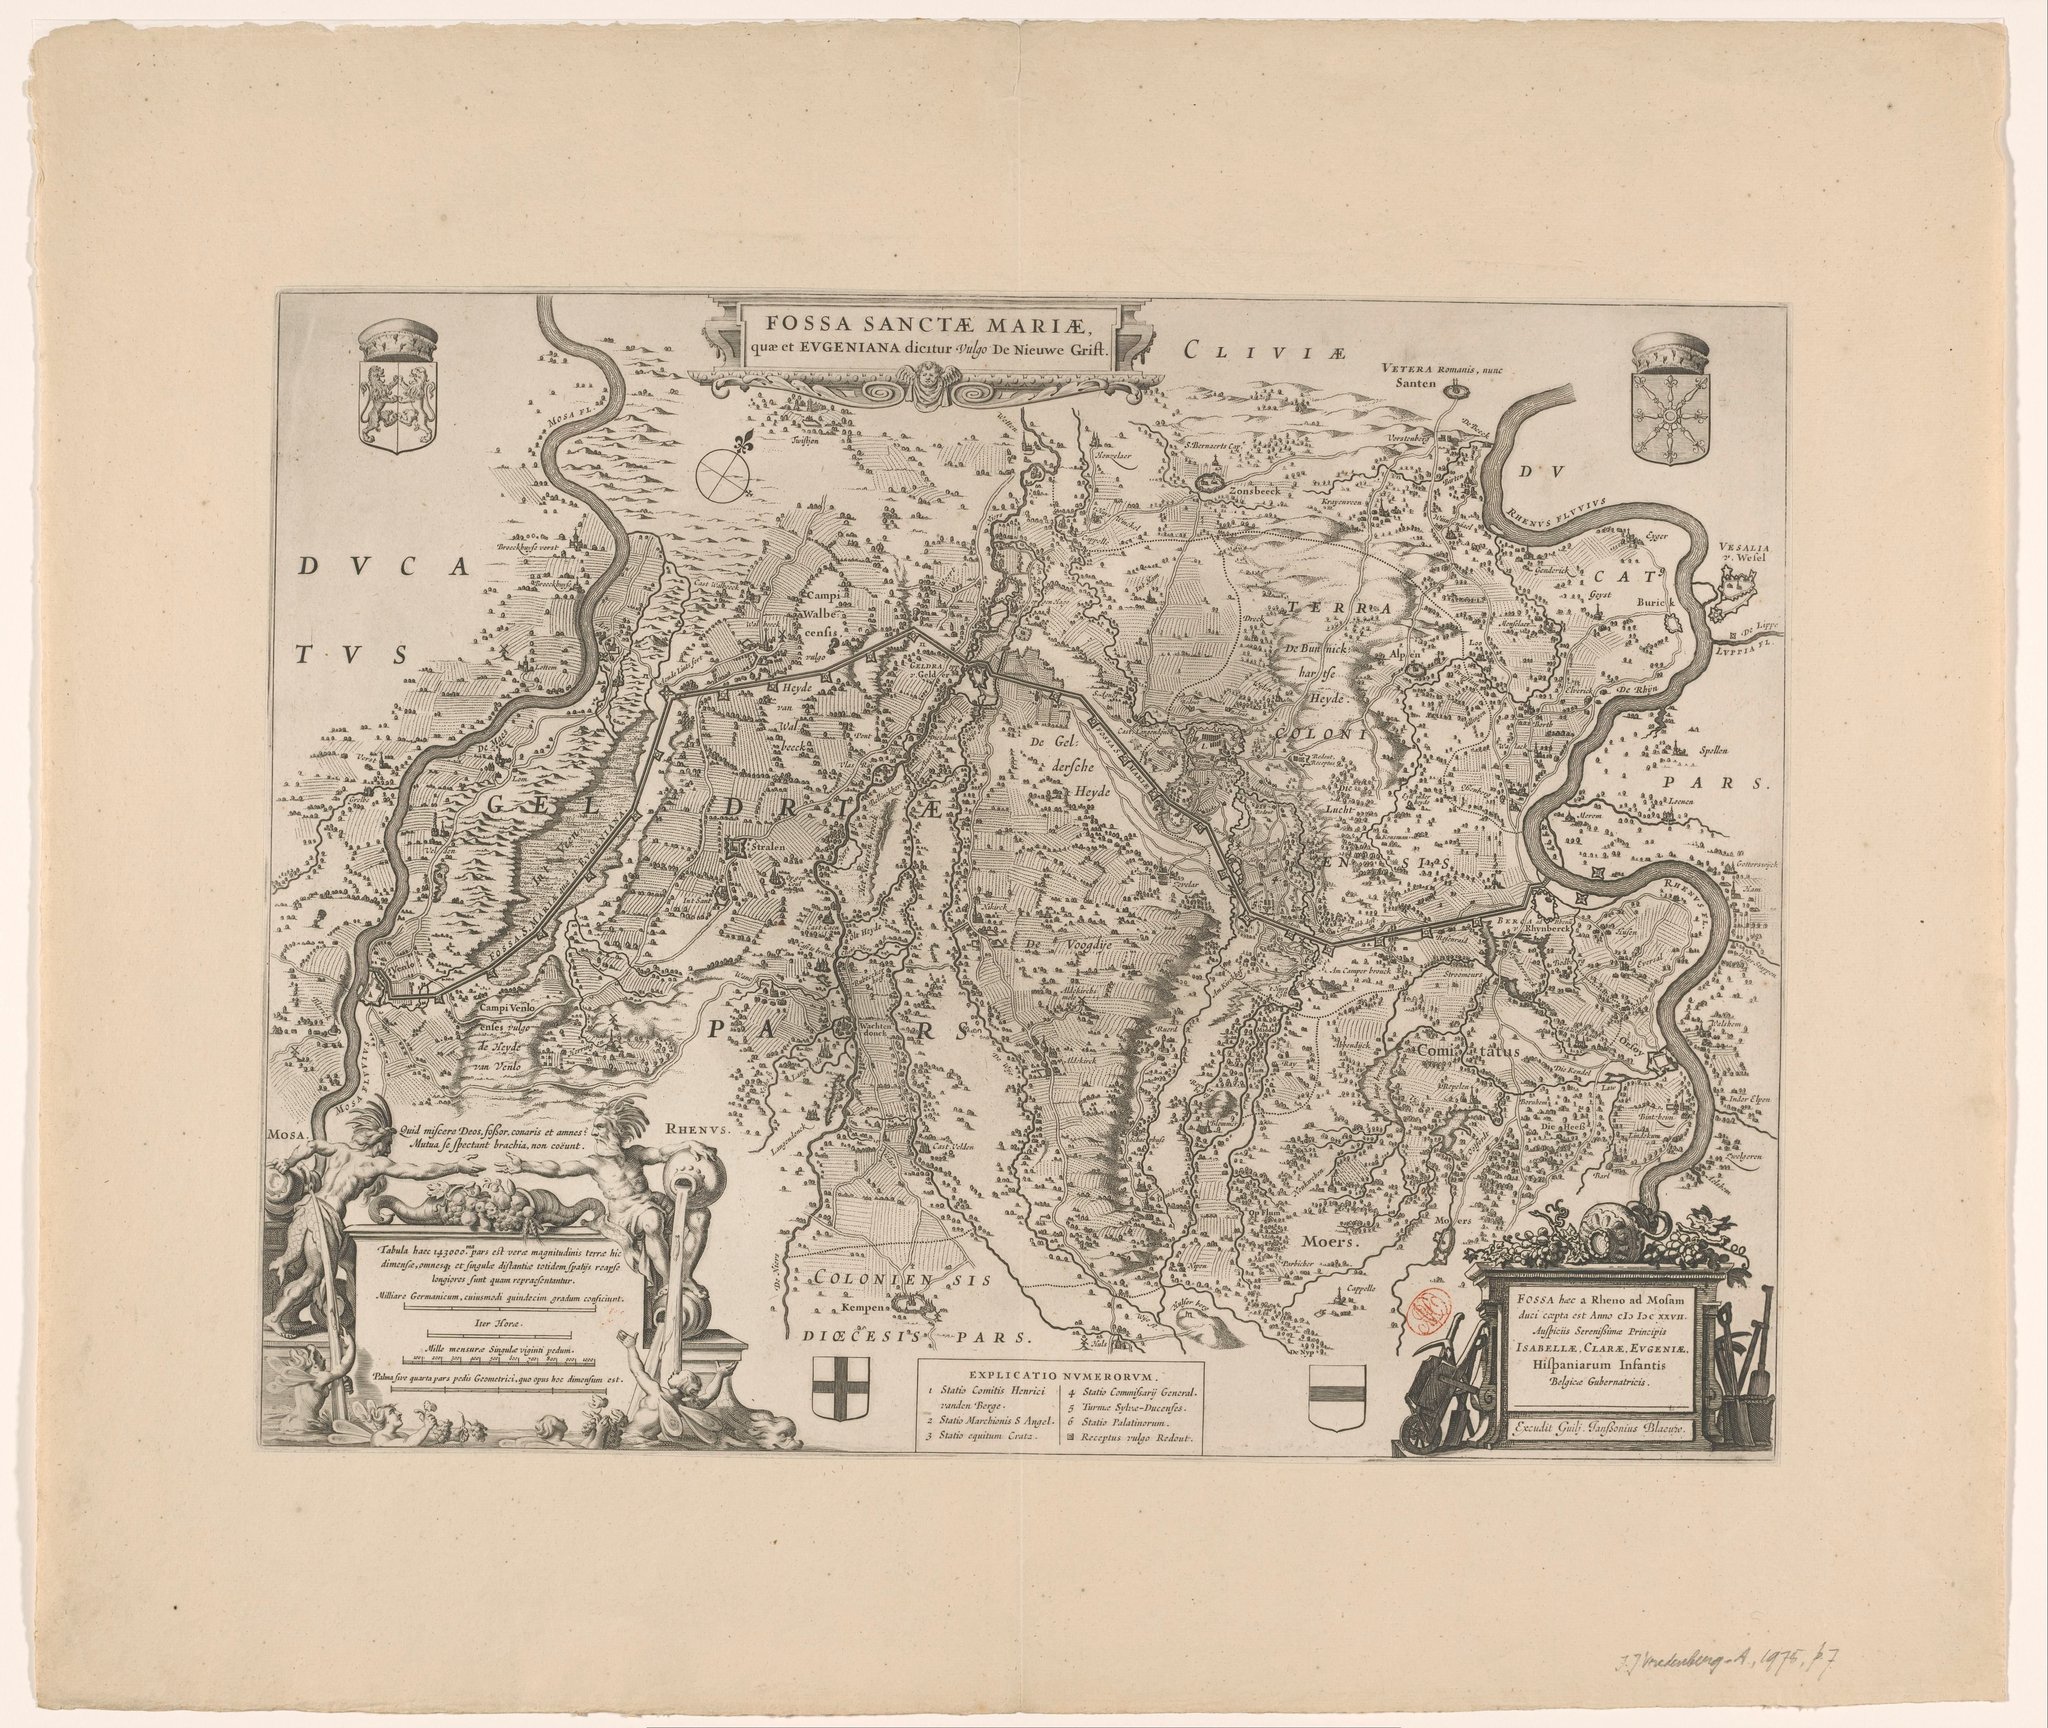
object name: print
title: Fossa Sanctae Mariae, quae et Eugeniana dicitur vulgo De Nieuwe Grist / Fossa haec a Rheno ad Mosam duci coepta est Anno MDCXXVII. Auspiciis Serenissimae Principis Isabellae, Clarae, Eugeniae, Hispaniarum Infantis Belgicae Gubernatricis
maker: Anonymous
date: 1627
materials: paper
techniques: engraving, etching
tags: infante van spanje isabella clara eugenia, construction of canal, maps of separate countries or regions, river personified, 'fiumi' (ripa) - hh - ideal landscapes, coat of arms (as symbol of the state, etc.) (+ province; provincial), guelders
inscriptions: collector's mark: Lugt 195, collector's mark: Lugt 2228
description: Kaart met het kanaal genaamd Fossa Eugeniana tussen Rijnberg aan de Rijn en Venlo aan de Maas. Boven, in het midden, de titelcartouche. Rechtsonder een cartouche met Latijnse tekst. Onder, in het midden, een kader met legenda 1-6. Linksonder een cartouche met vier schaalstokken, met personificaties van de Rijn en de Maas die elkaar de hand reiken. Linksboven het wapen van het hertogdom Gelre, rechtsboven het wapen van het hertogdom Kleef. Onder, rechts van het midden, het wapen van het vorstendom Meurs. Onder, links van het midden, het wapen van het aartsbisdom Keulen.